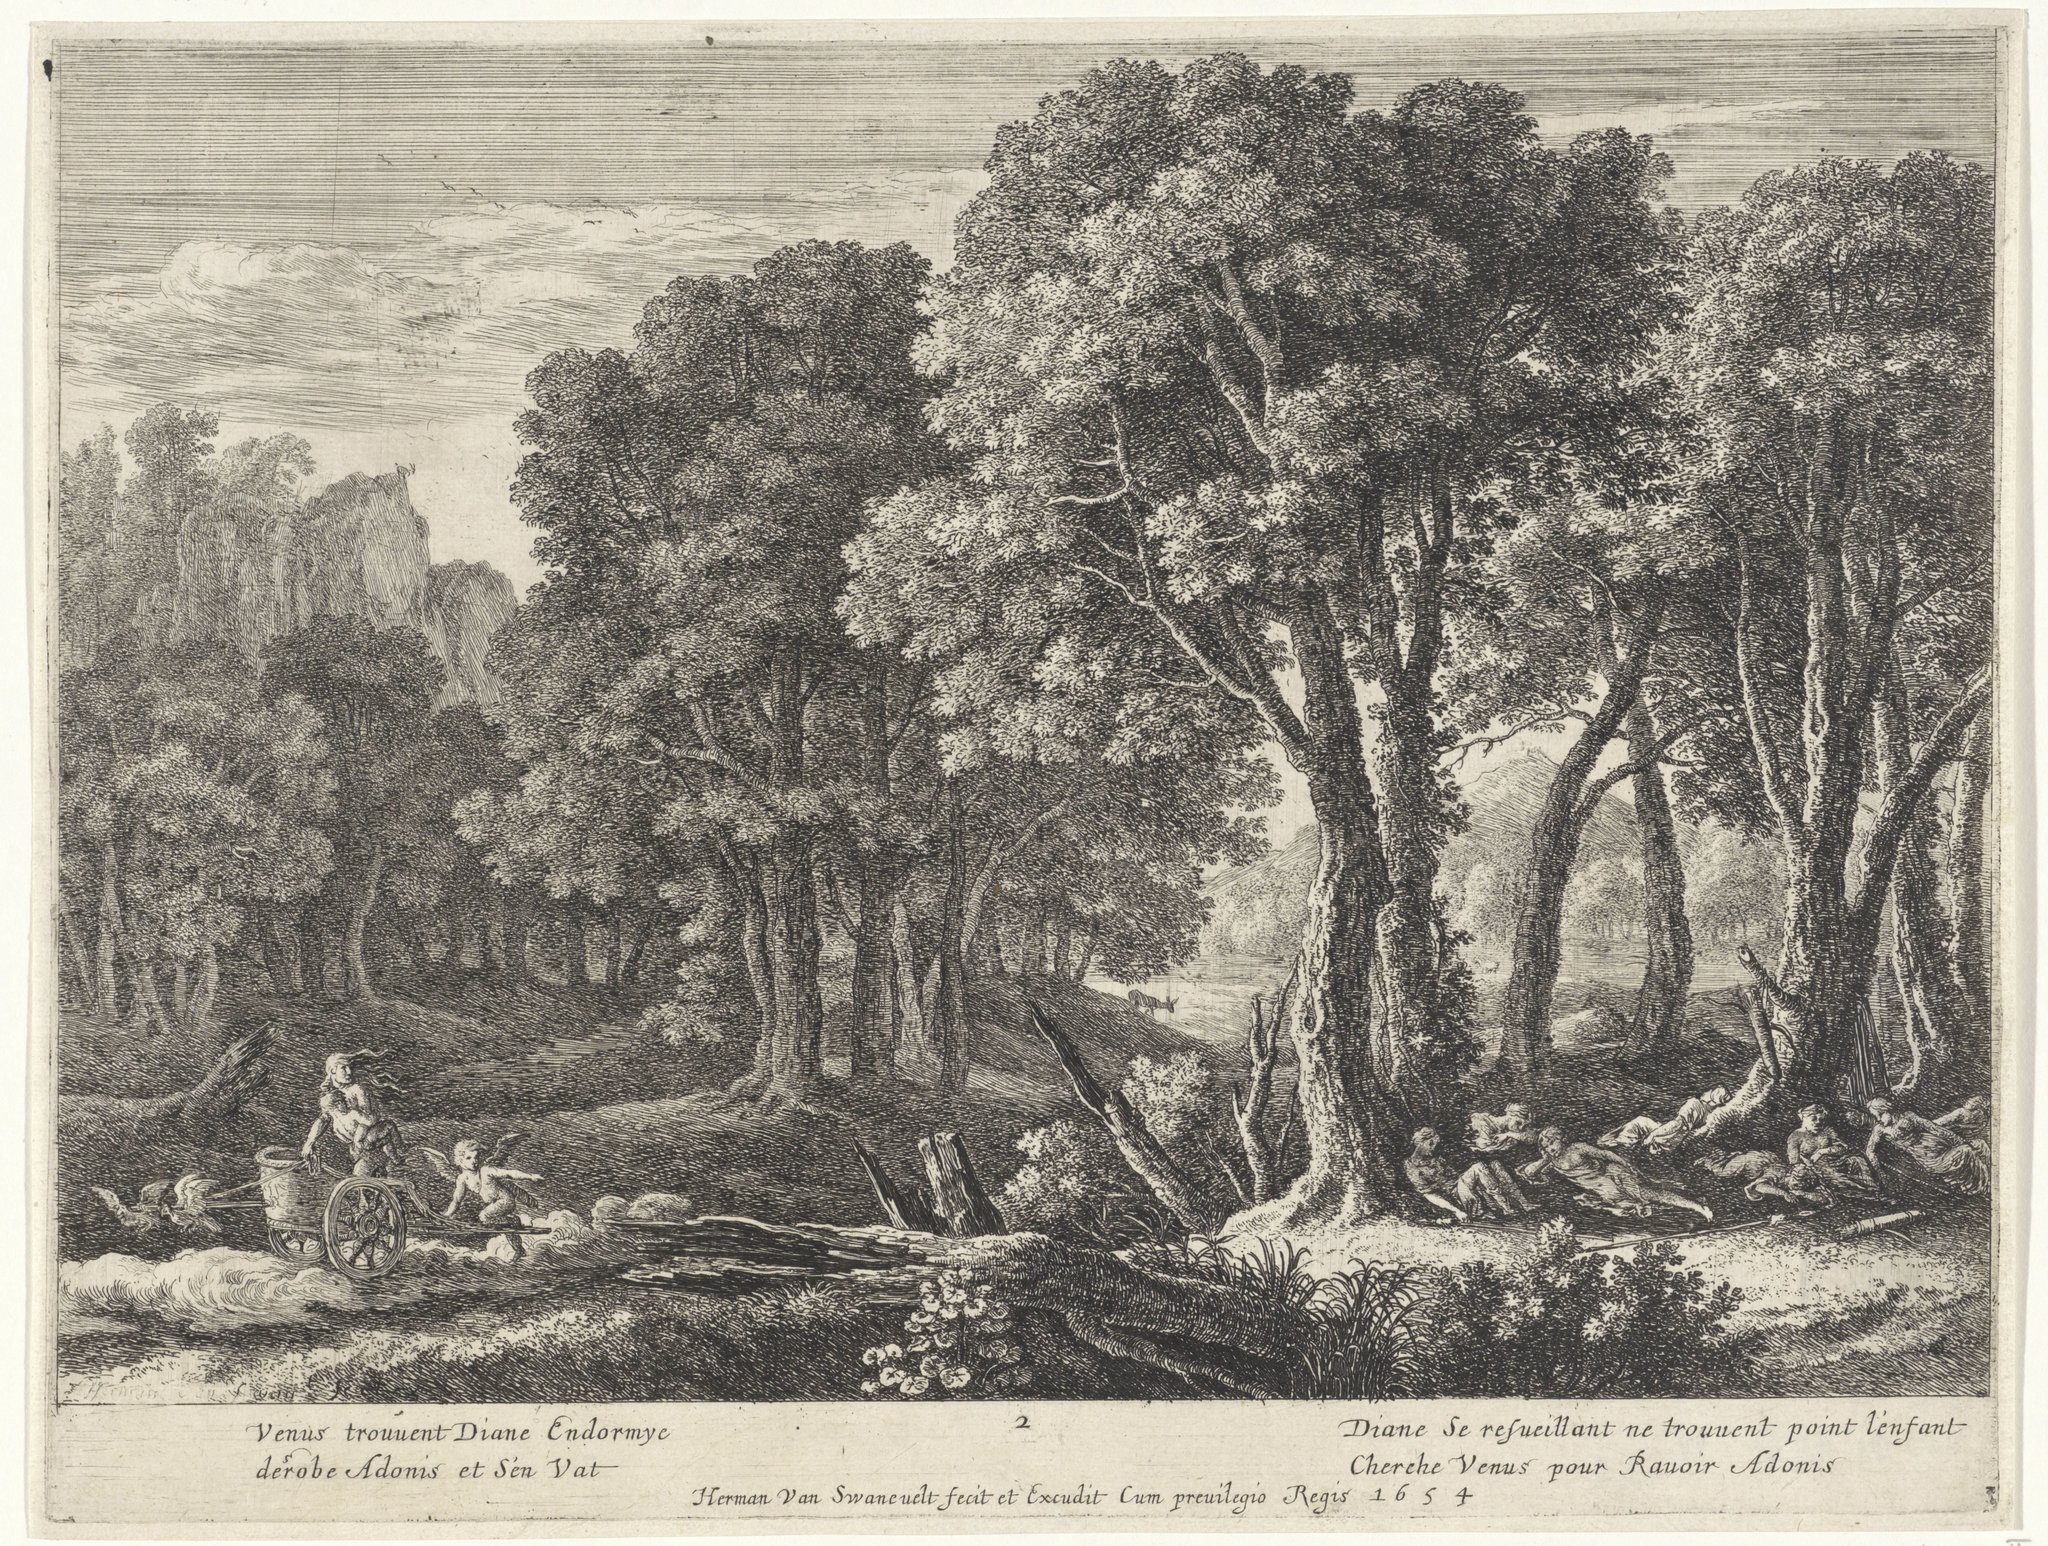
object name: print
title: Venus ontvoert Adonis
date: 1654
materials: paper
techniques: etching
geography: paris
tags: (story of) adonis, (story of) diana (artemis), (story of) venus (aphrodite)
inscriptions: collector's mark: Lugt 11, collector's mark: Lugt 10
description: In een bosrijk landschap rijdt Venus links op de voorgrond met wapperend haar in een strijdwagen die wordt voortgetrokken door twee duiven. In haar linkerarm houdt ze Adonis en achter haar knielt Cupido op de wagen. Rechts slaapt Diana temidden van enkele waternimfen. Op de grond liggen wapens. Onderaan wordt de episode in het verhaal toegelicht in een vierregelige, Franse tekst.